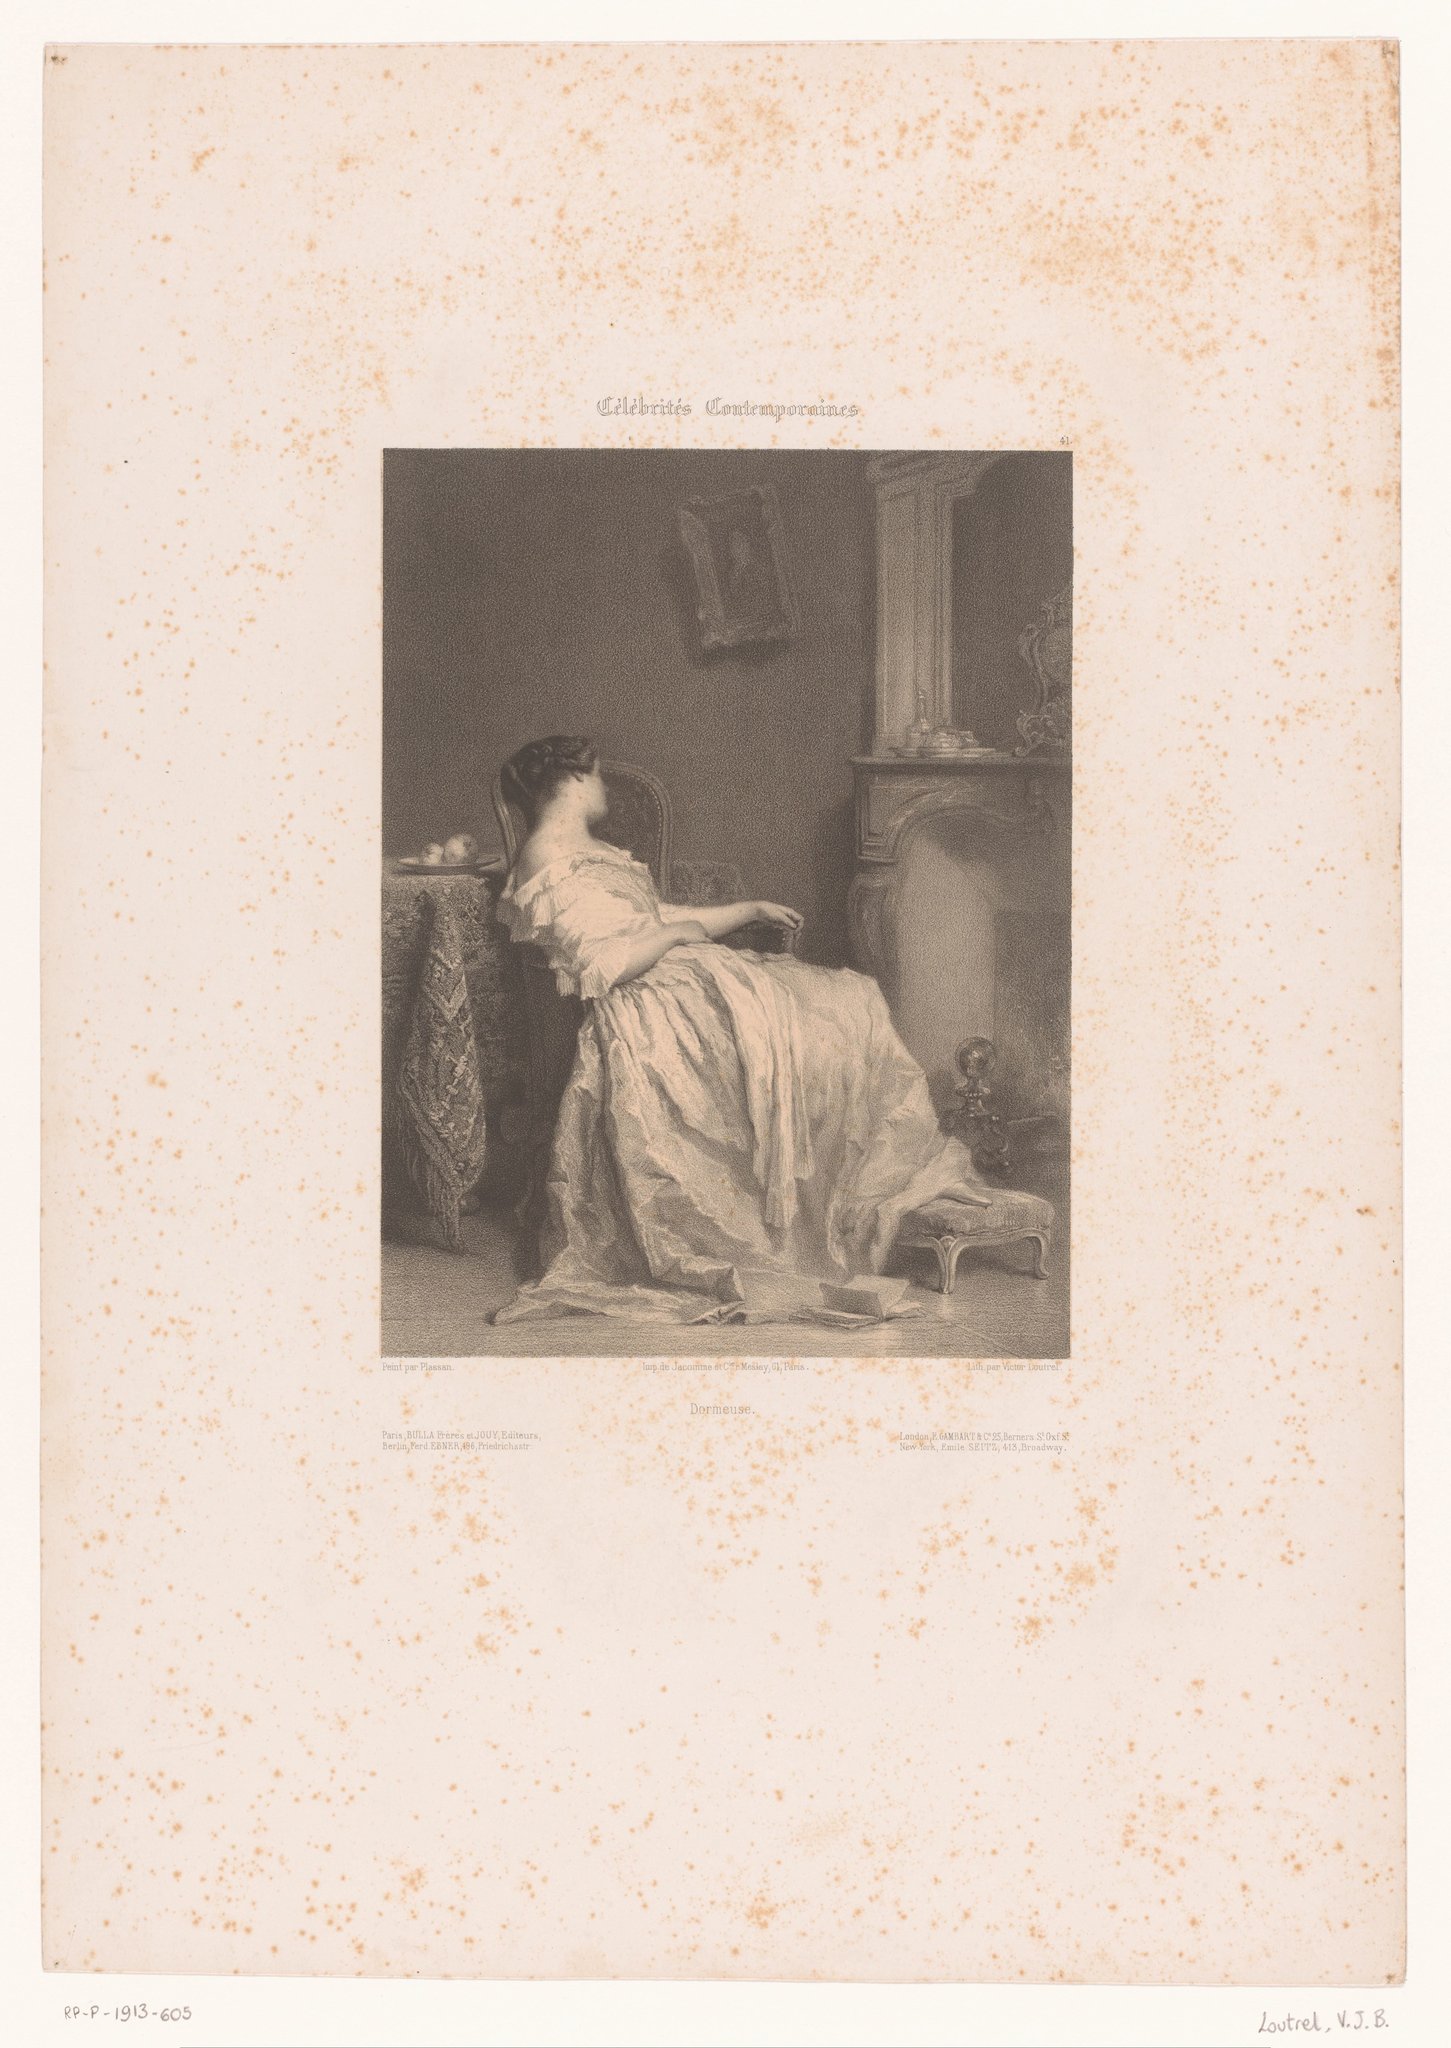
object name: print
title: Werken van bekende hedendaagse kunstenaars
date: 1854-1858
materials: paper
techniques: lithograph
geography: london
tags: sitting figure, adult woman, interior of the house, sleeping; unconsciousness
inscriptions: collector's mark: Lugt 2233